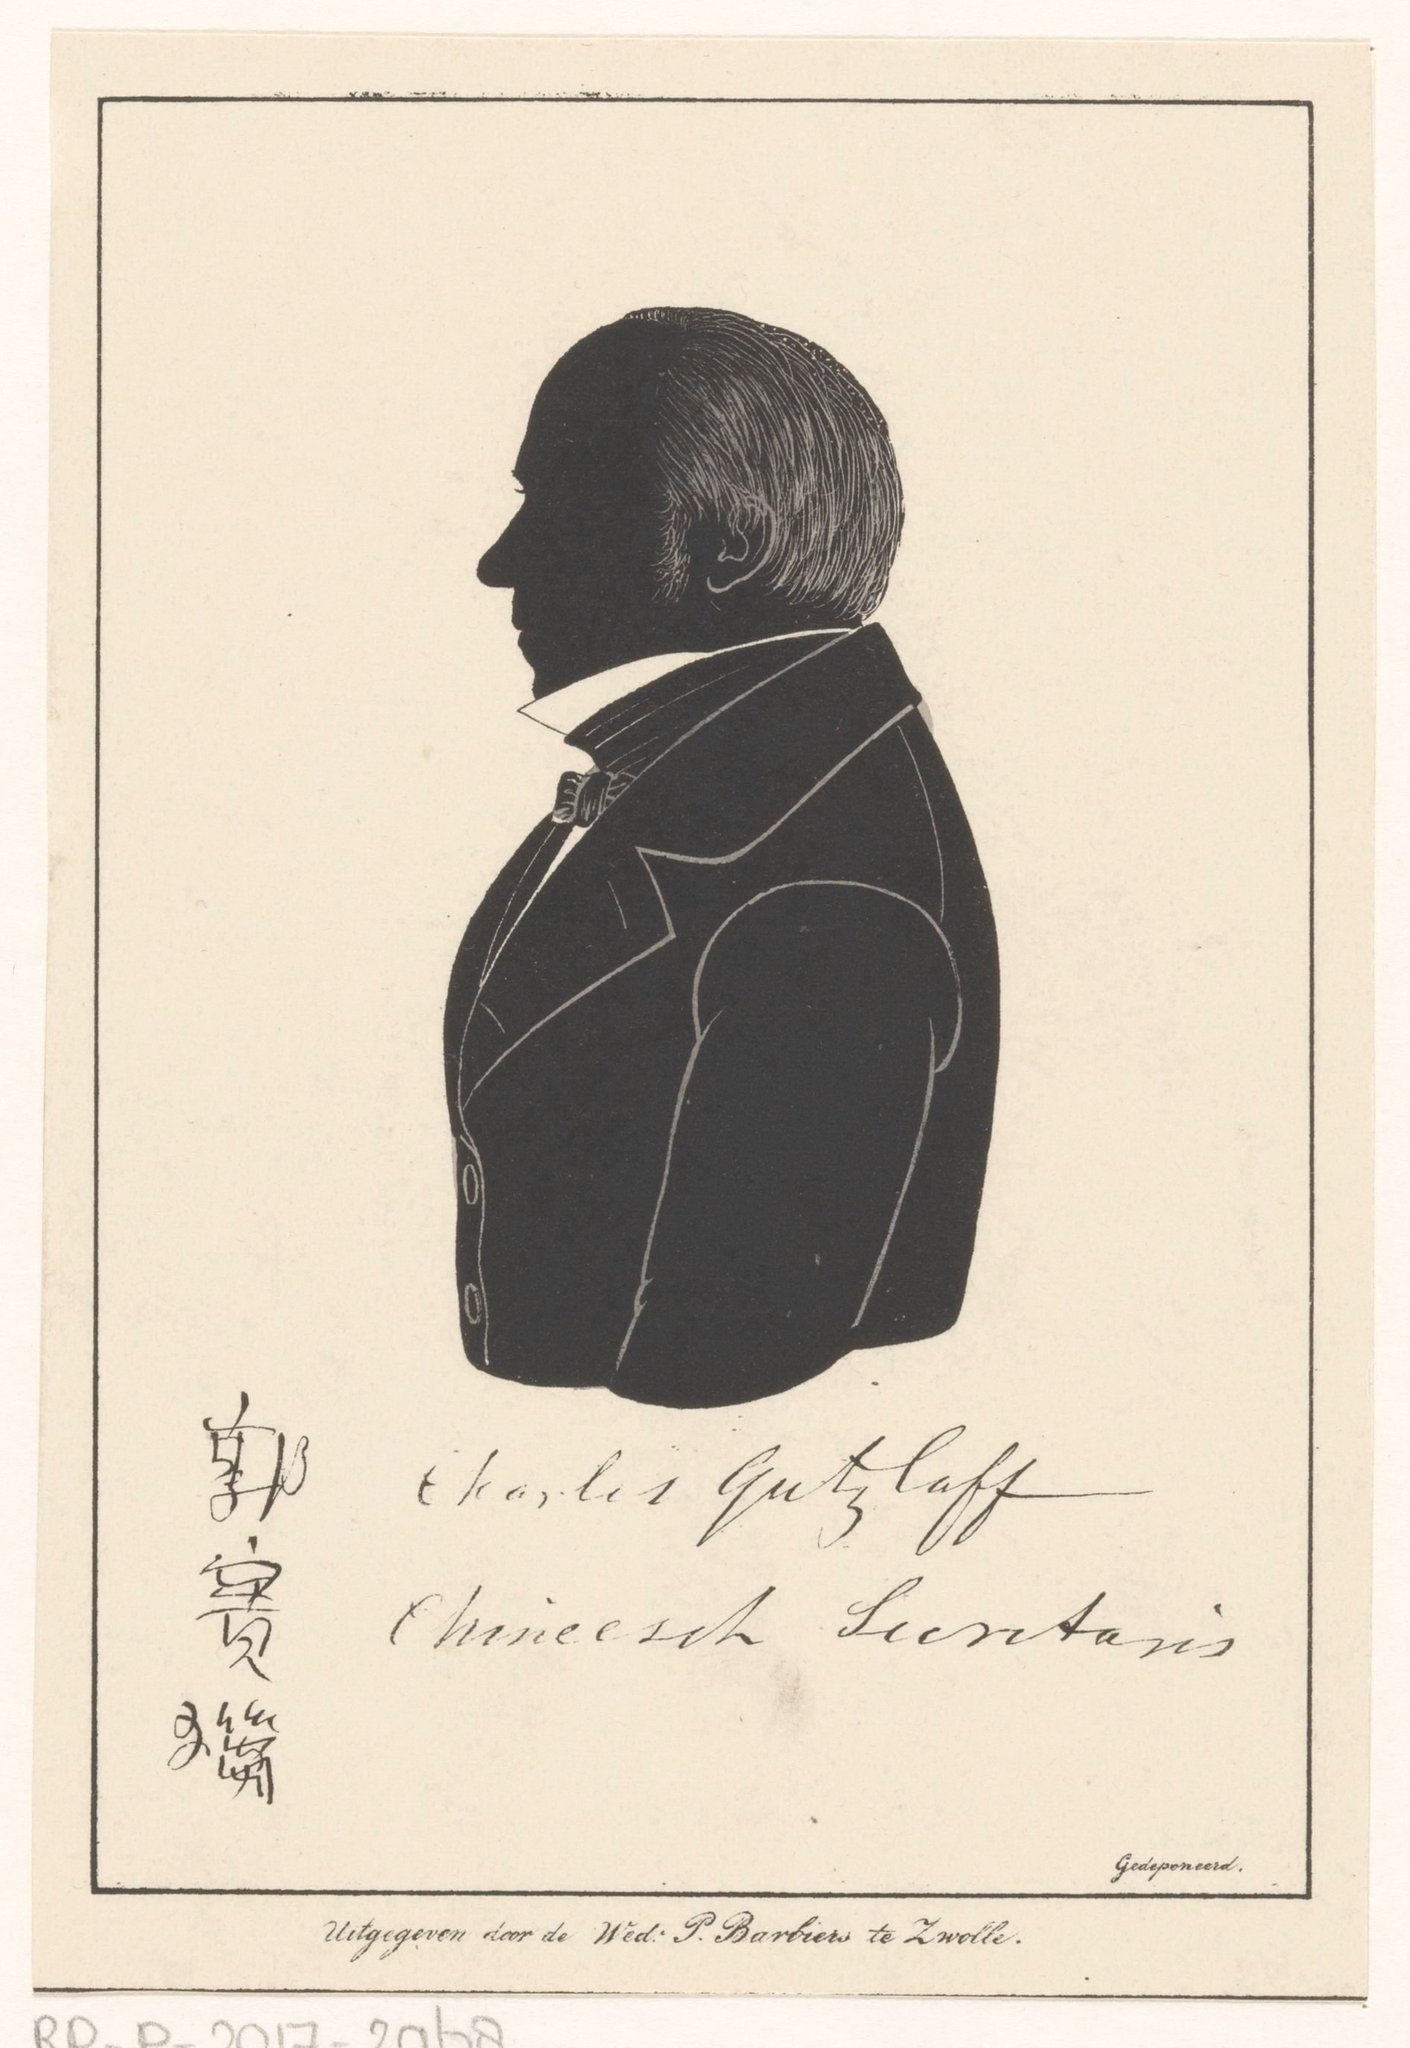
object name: print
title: Silhouetportret van Karl Friedrich August Gützlaff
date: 1848-1862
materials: paper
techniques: hand coloring, lithograph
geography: zwolle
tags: historical persons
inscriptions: collector's mark: Lugt 2228, : ‘Gedeponeerd.’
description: Onder het portret de signatuur van de geportretteerde.